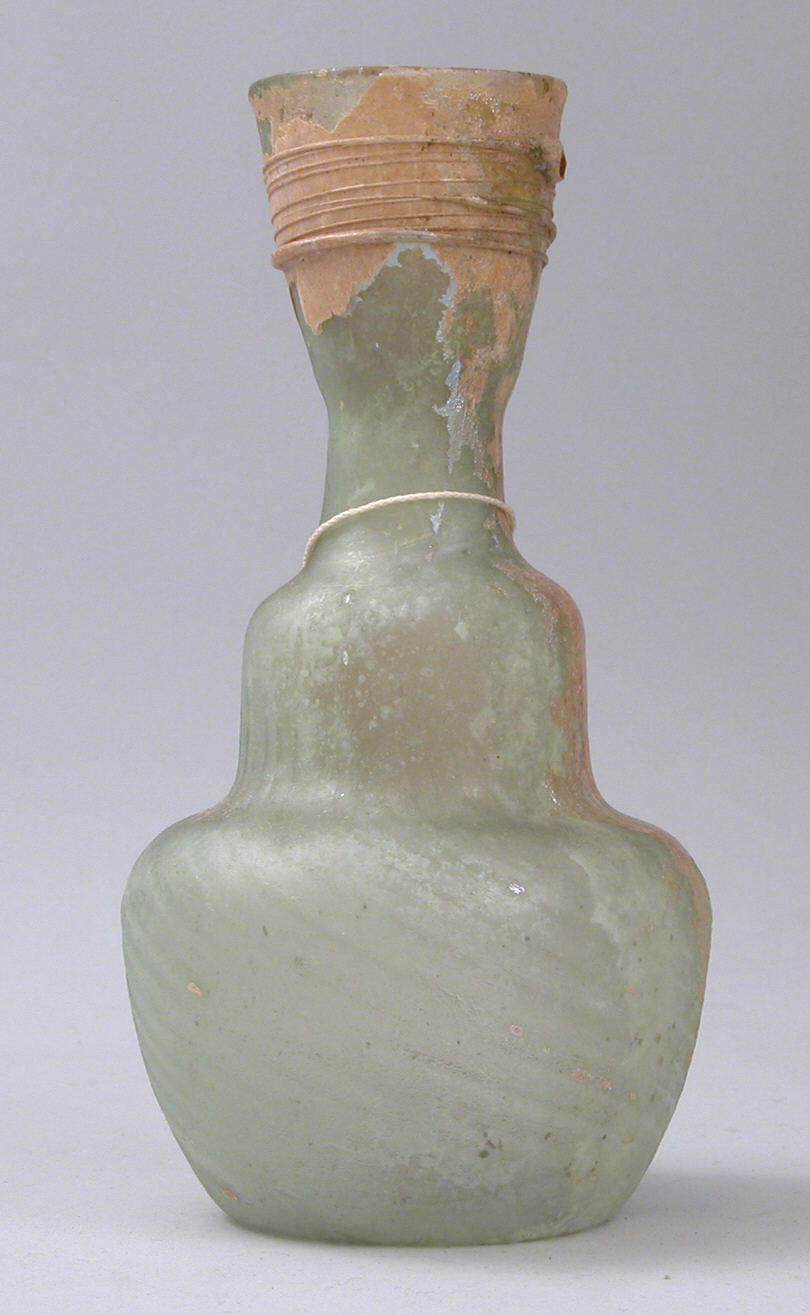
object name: bottle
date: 501-700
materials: glass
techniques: glassblowing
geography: syria